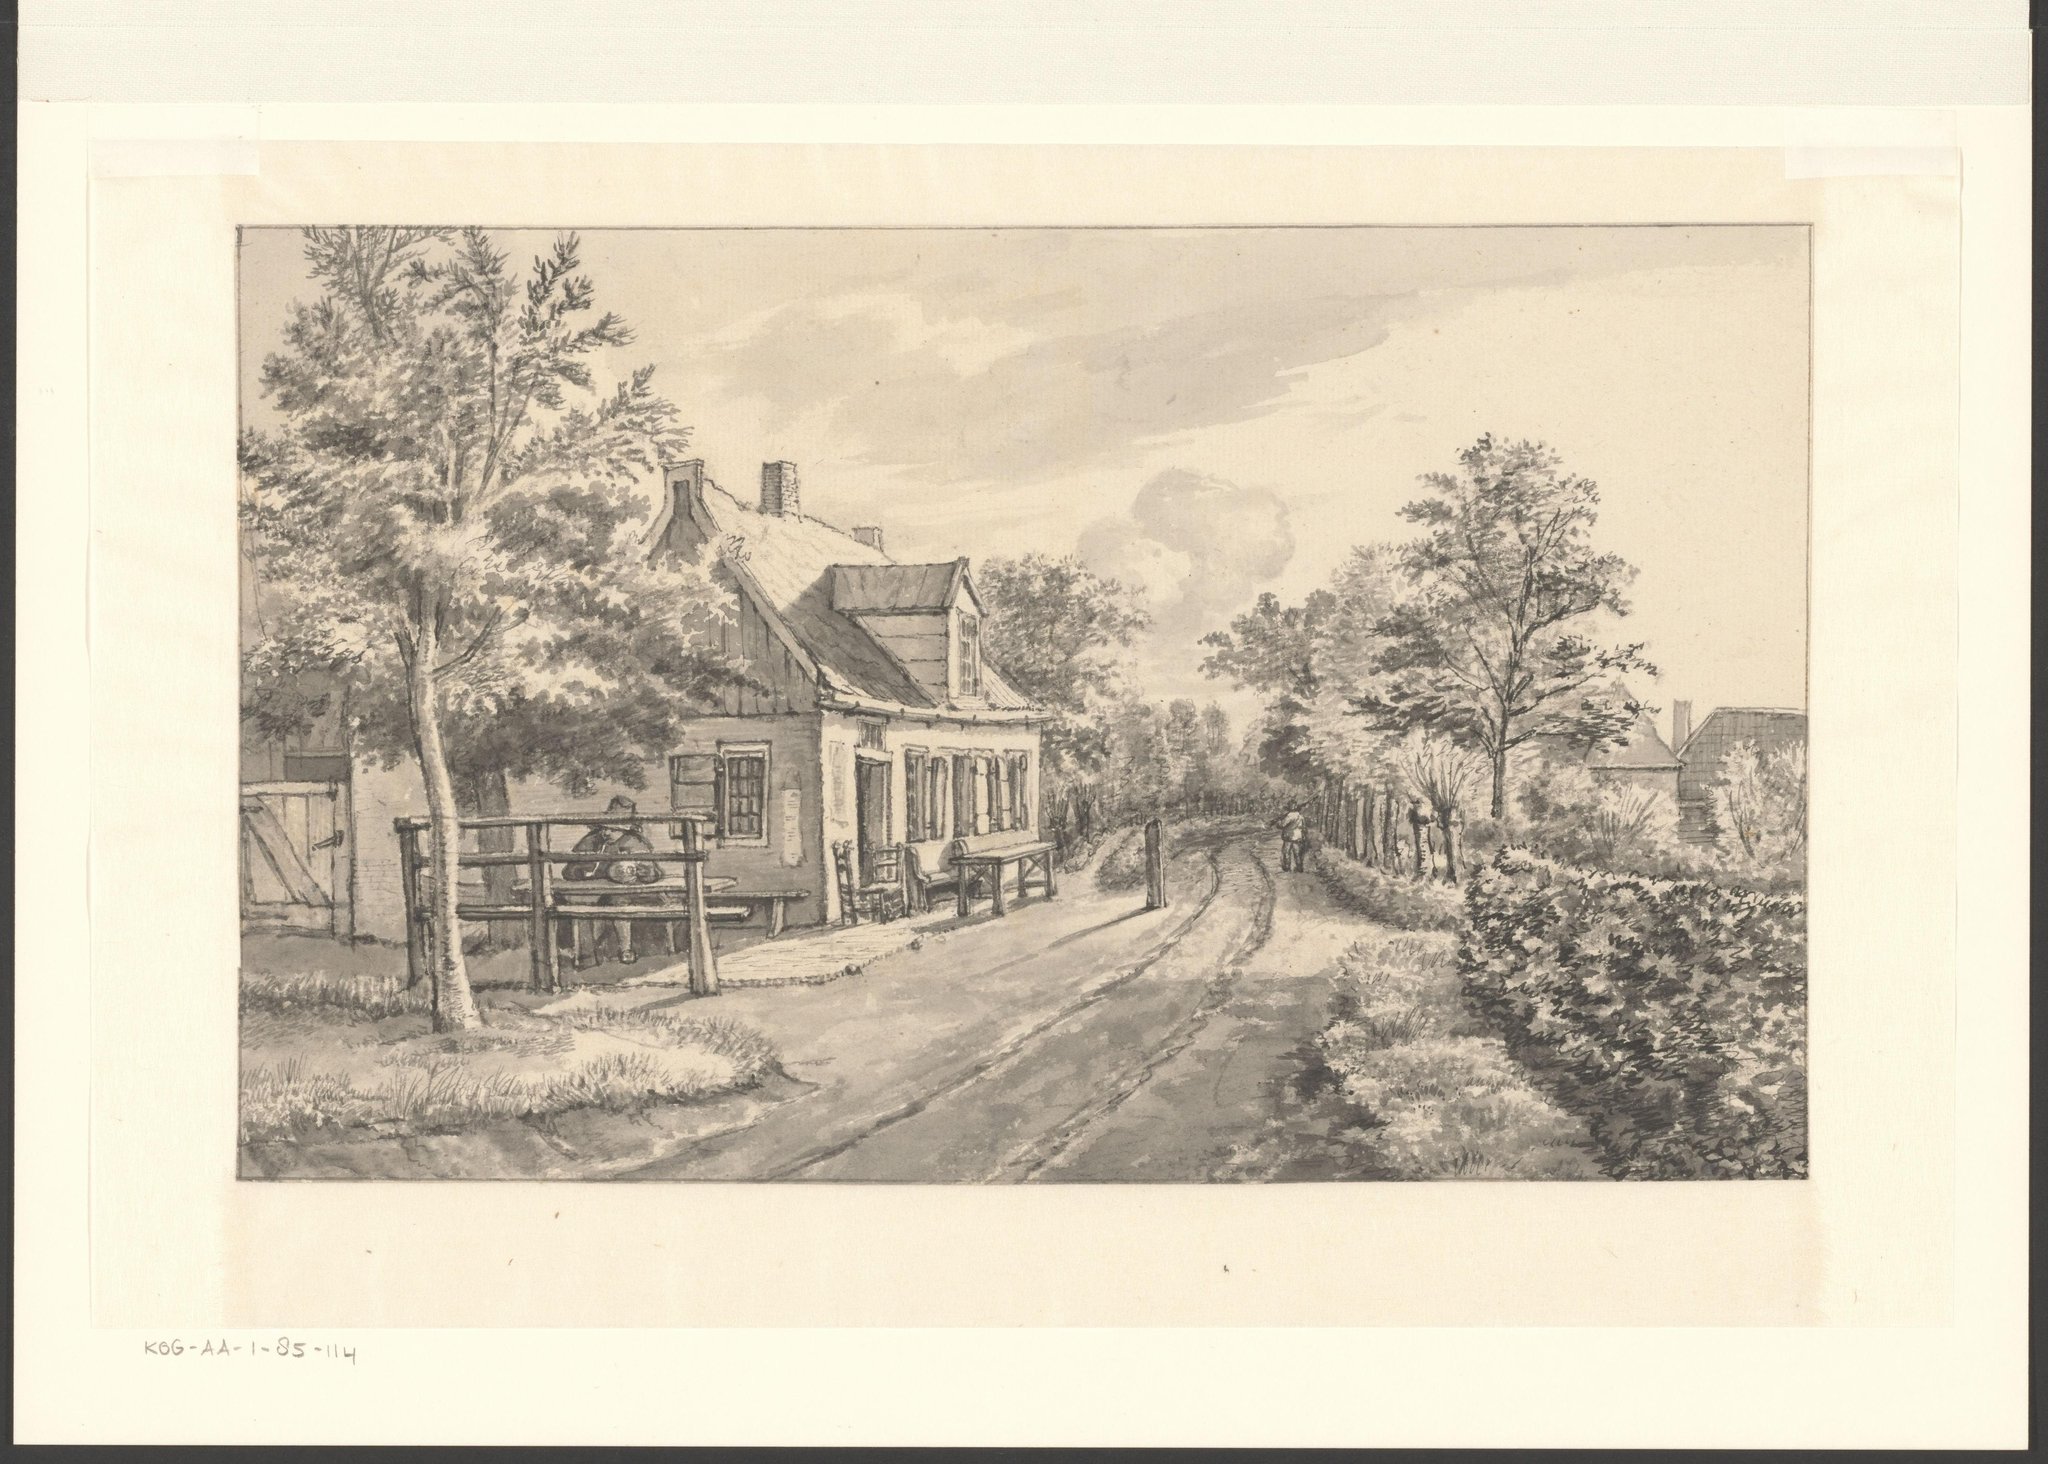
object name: drawing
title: Gezicht op de Sloterweg met herberg Het Dronkemanshuisje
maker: gerrit lamberts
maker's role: bookseller, draughtsman, print maker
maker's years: 1776-1850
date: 1816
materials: chalk, ink, paper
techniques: brush, pen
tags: city-view in general; 'veduta', road, path, hotel, hostelry, inn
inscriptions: signature, date and inscription: ‘Het Dronkemans huisje / op de Sloterweg. / G. Lamberts. 1816.’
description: Onderwerpsrubriek binnen de Atlas Amsterdam: Haarlemmermeer.